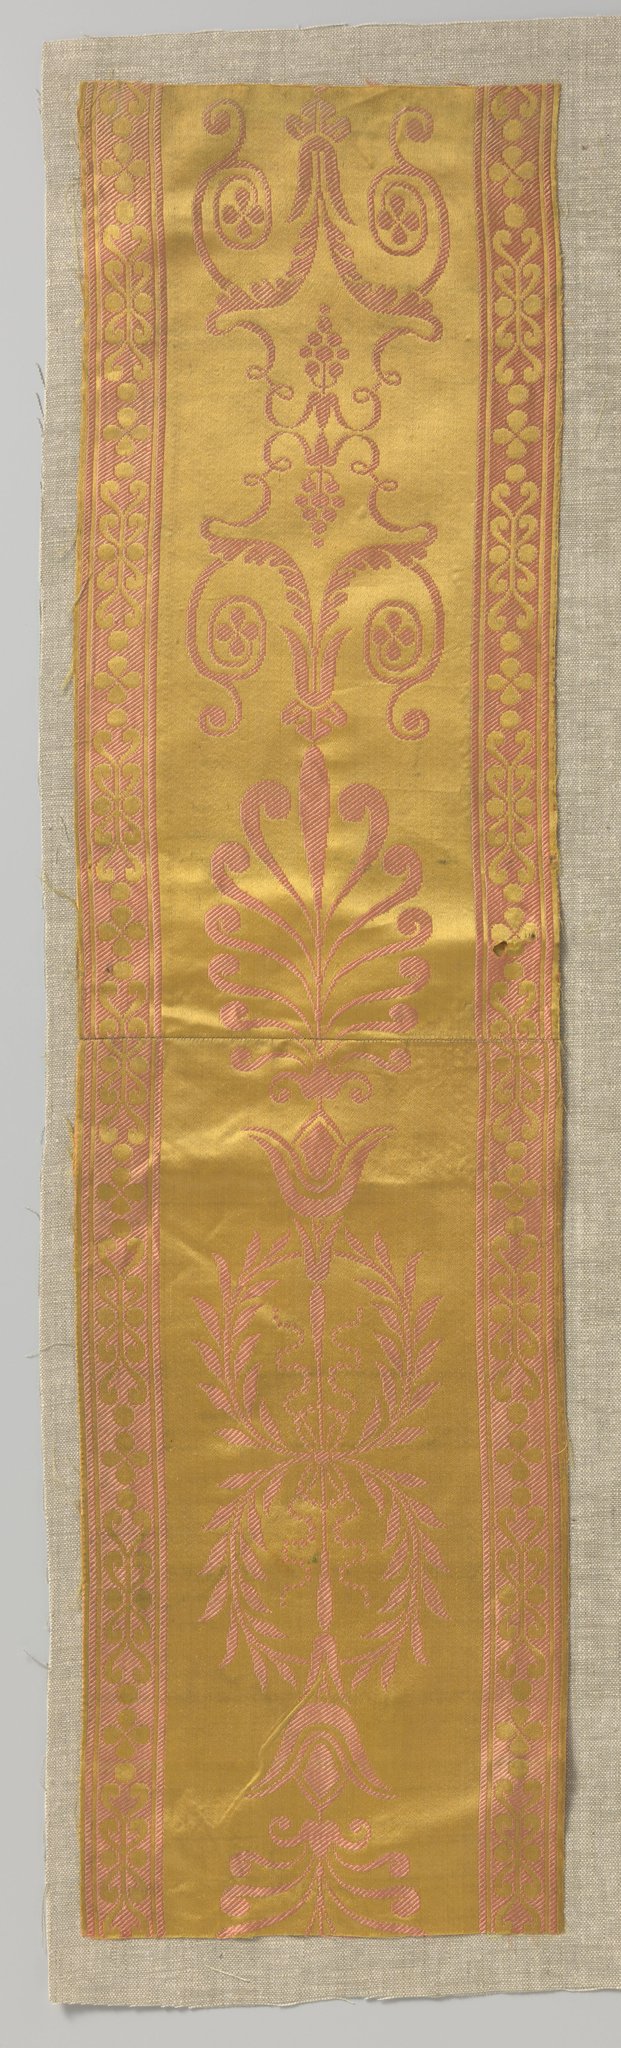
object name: zijdesatijn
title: Zijden rand, fragment, geweven op grond van geel satijn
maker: Anonymous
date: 1775-1800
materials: textile, silk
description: Zijden rand, fragment, geweven op grond van geel satijn een ornament in rood keper. Fragment A en B zijn aan elkaar genaaid.